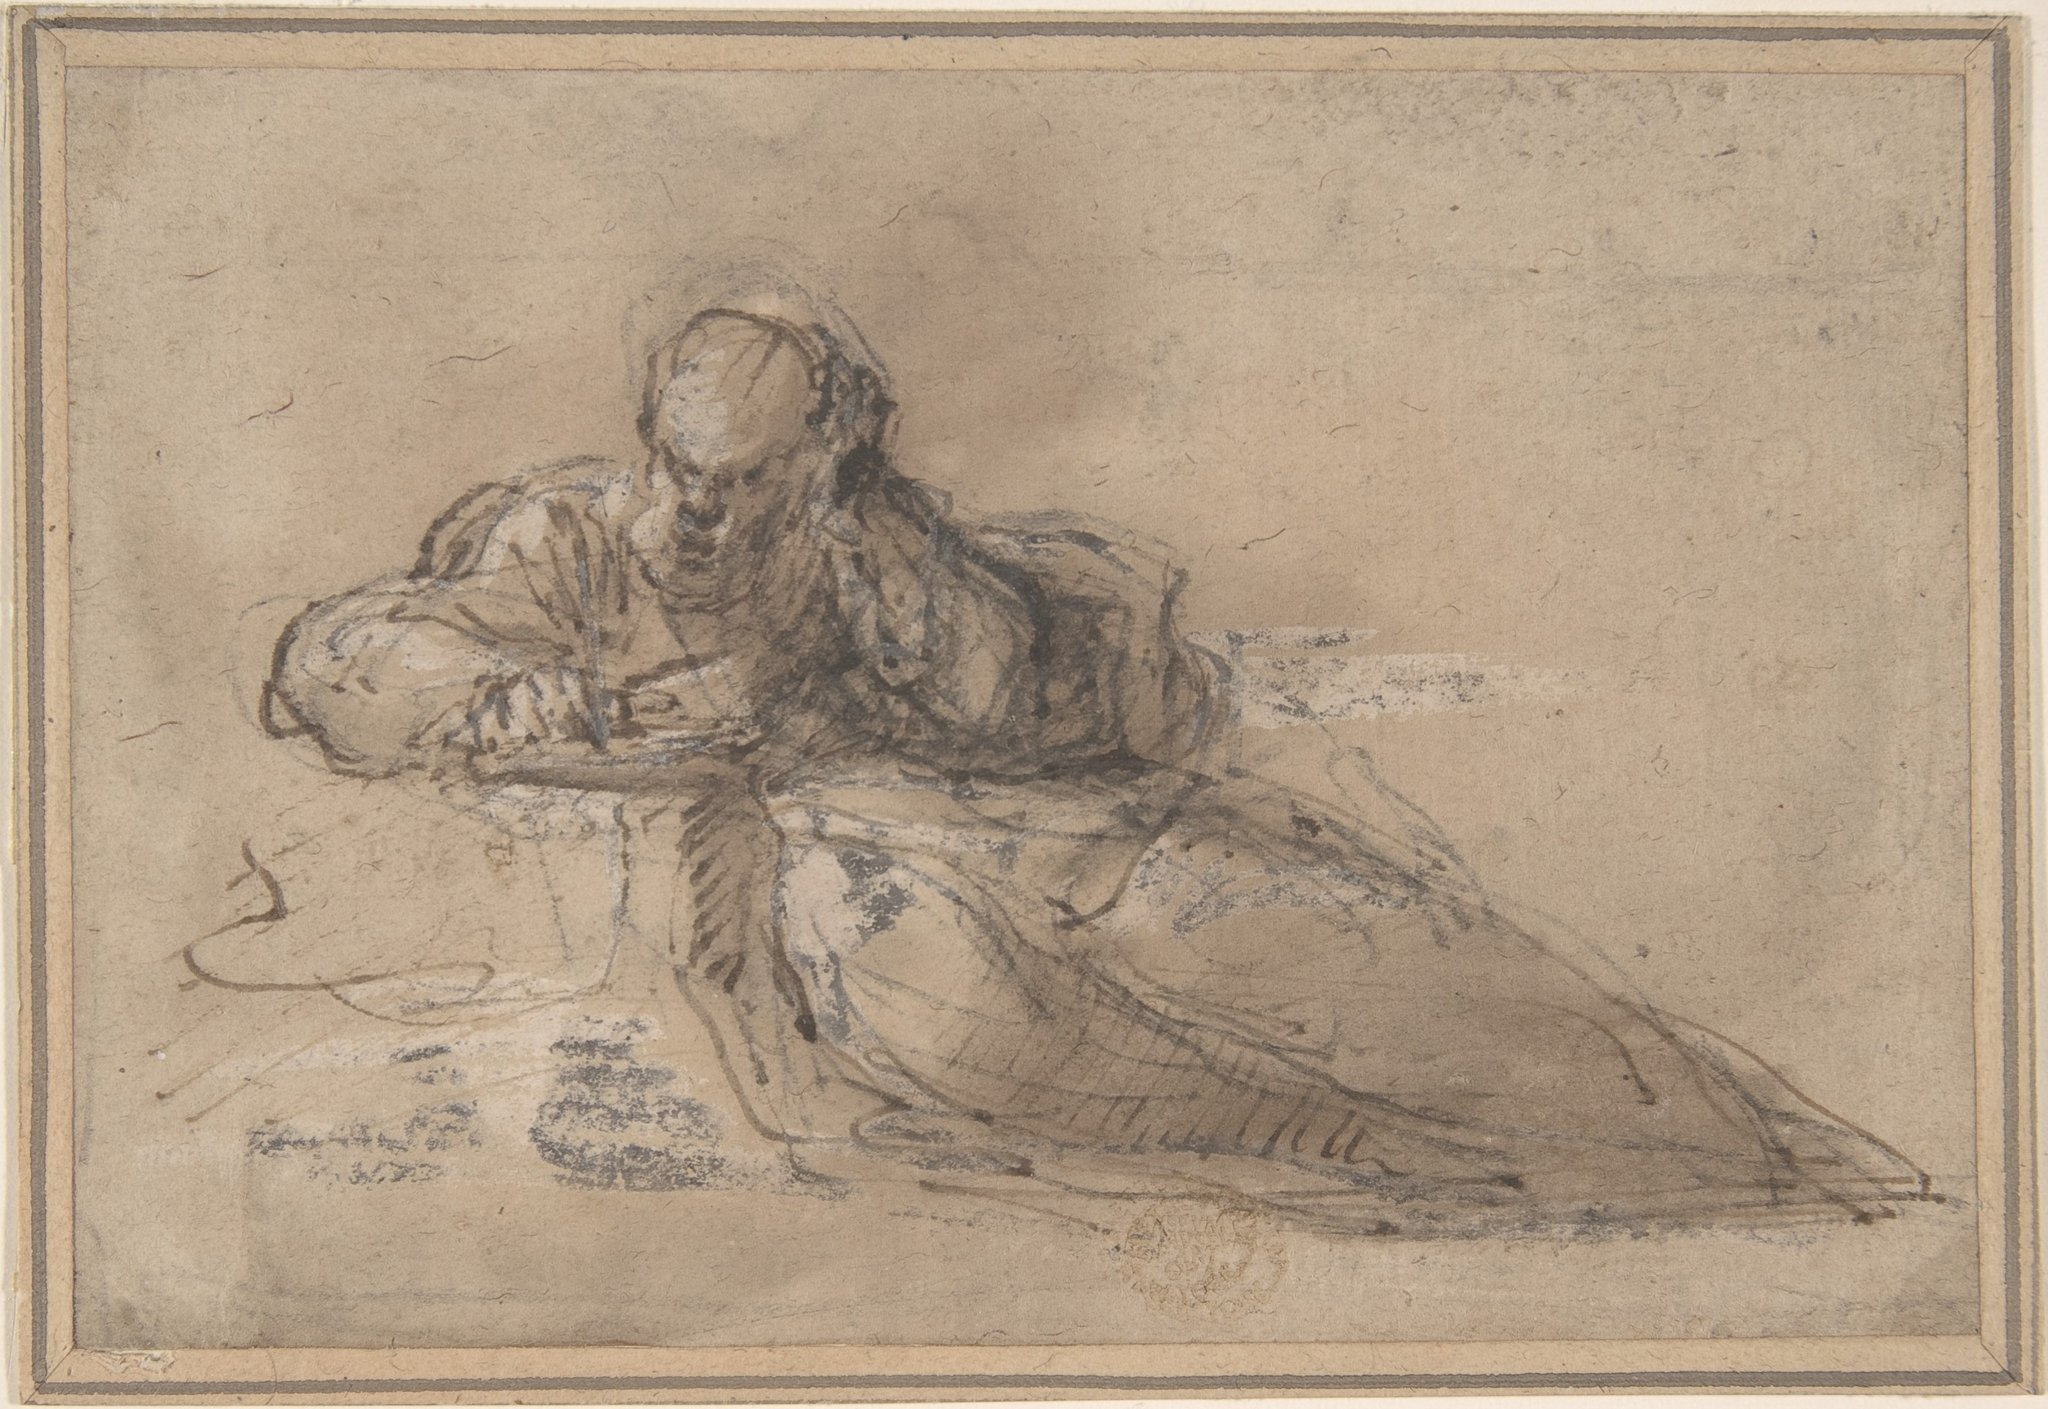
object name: drawing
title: Man Seated on the Ground, Writing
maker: anonymous, italian, roman-bolognese, 17th century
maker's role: artist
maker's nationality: italian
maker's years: 1600-1700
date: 1601-1700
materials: chalk, gouache, ink, paper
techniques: brush, highlighting, pen, wash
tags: men,writing